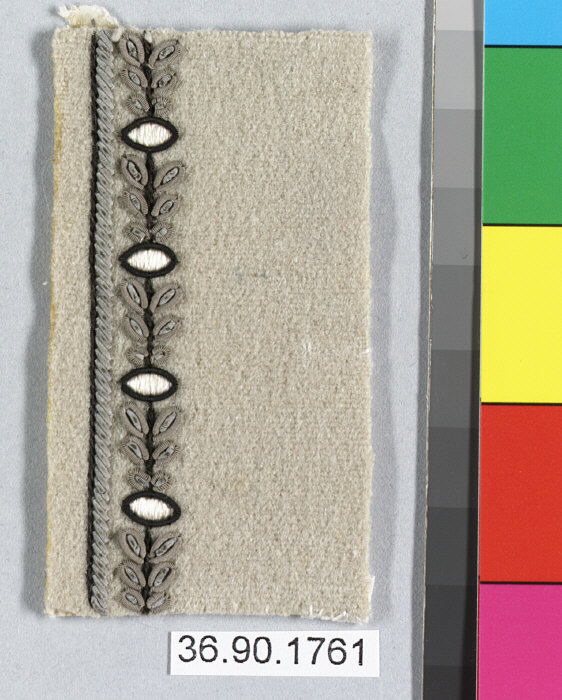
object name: sample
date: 1801-1833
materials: felt, metal thread, silk